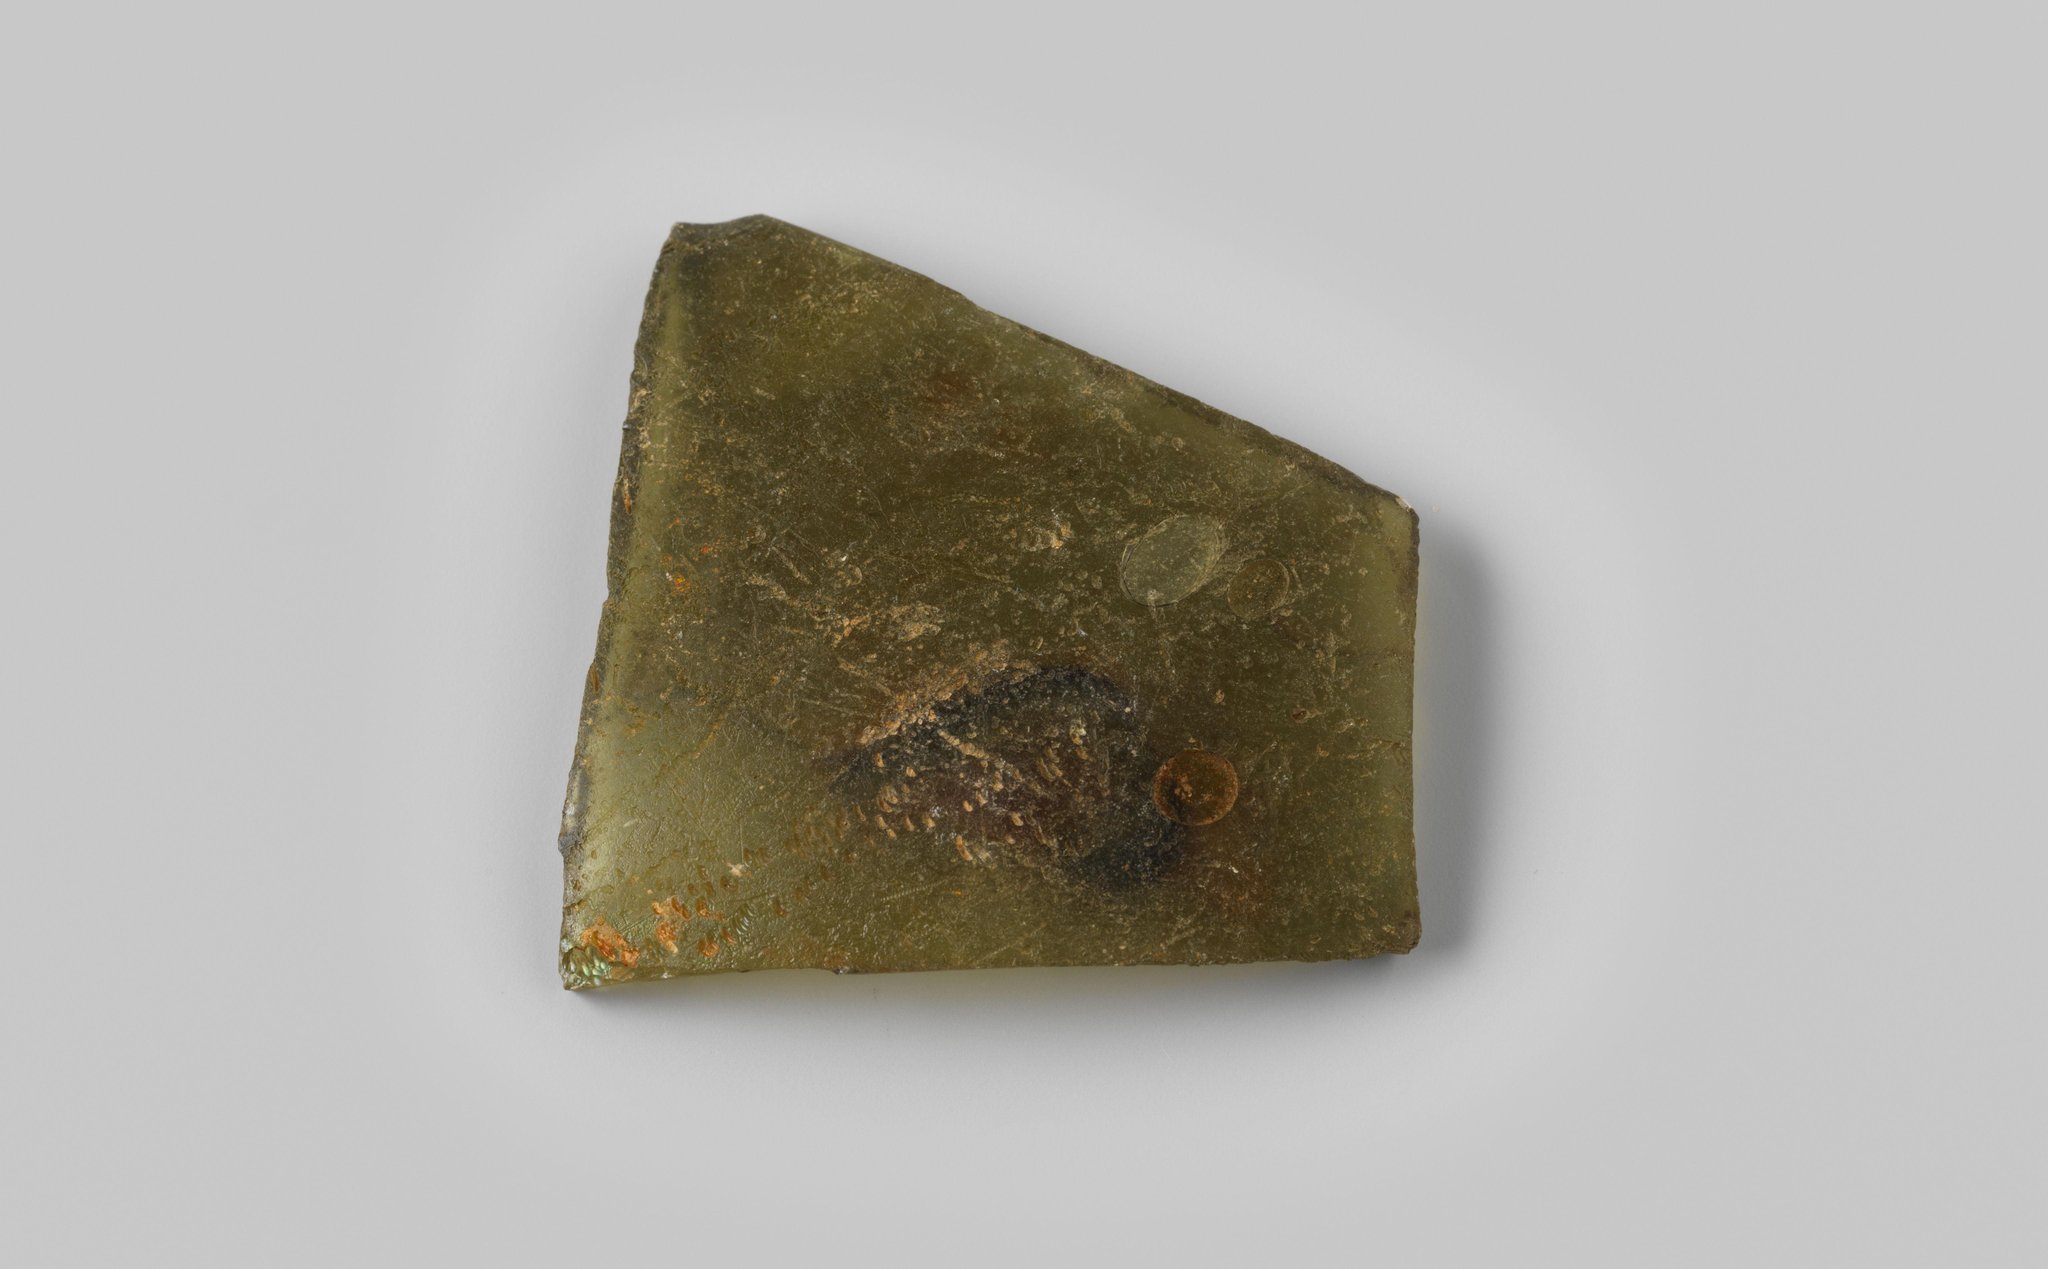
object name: sherd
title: Scherf van een wijnfles uit het wrak van de Oost-Indiëvaarder Hollandia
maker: Anonymous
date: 1700-1743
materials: glass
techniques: green glass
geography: netherlands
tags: verenigde oostindische compagnie, hollandia (schip), annet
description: Typologically not identifiable, belly, fragment.